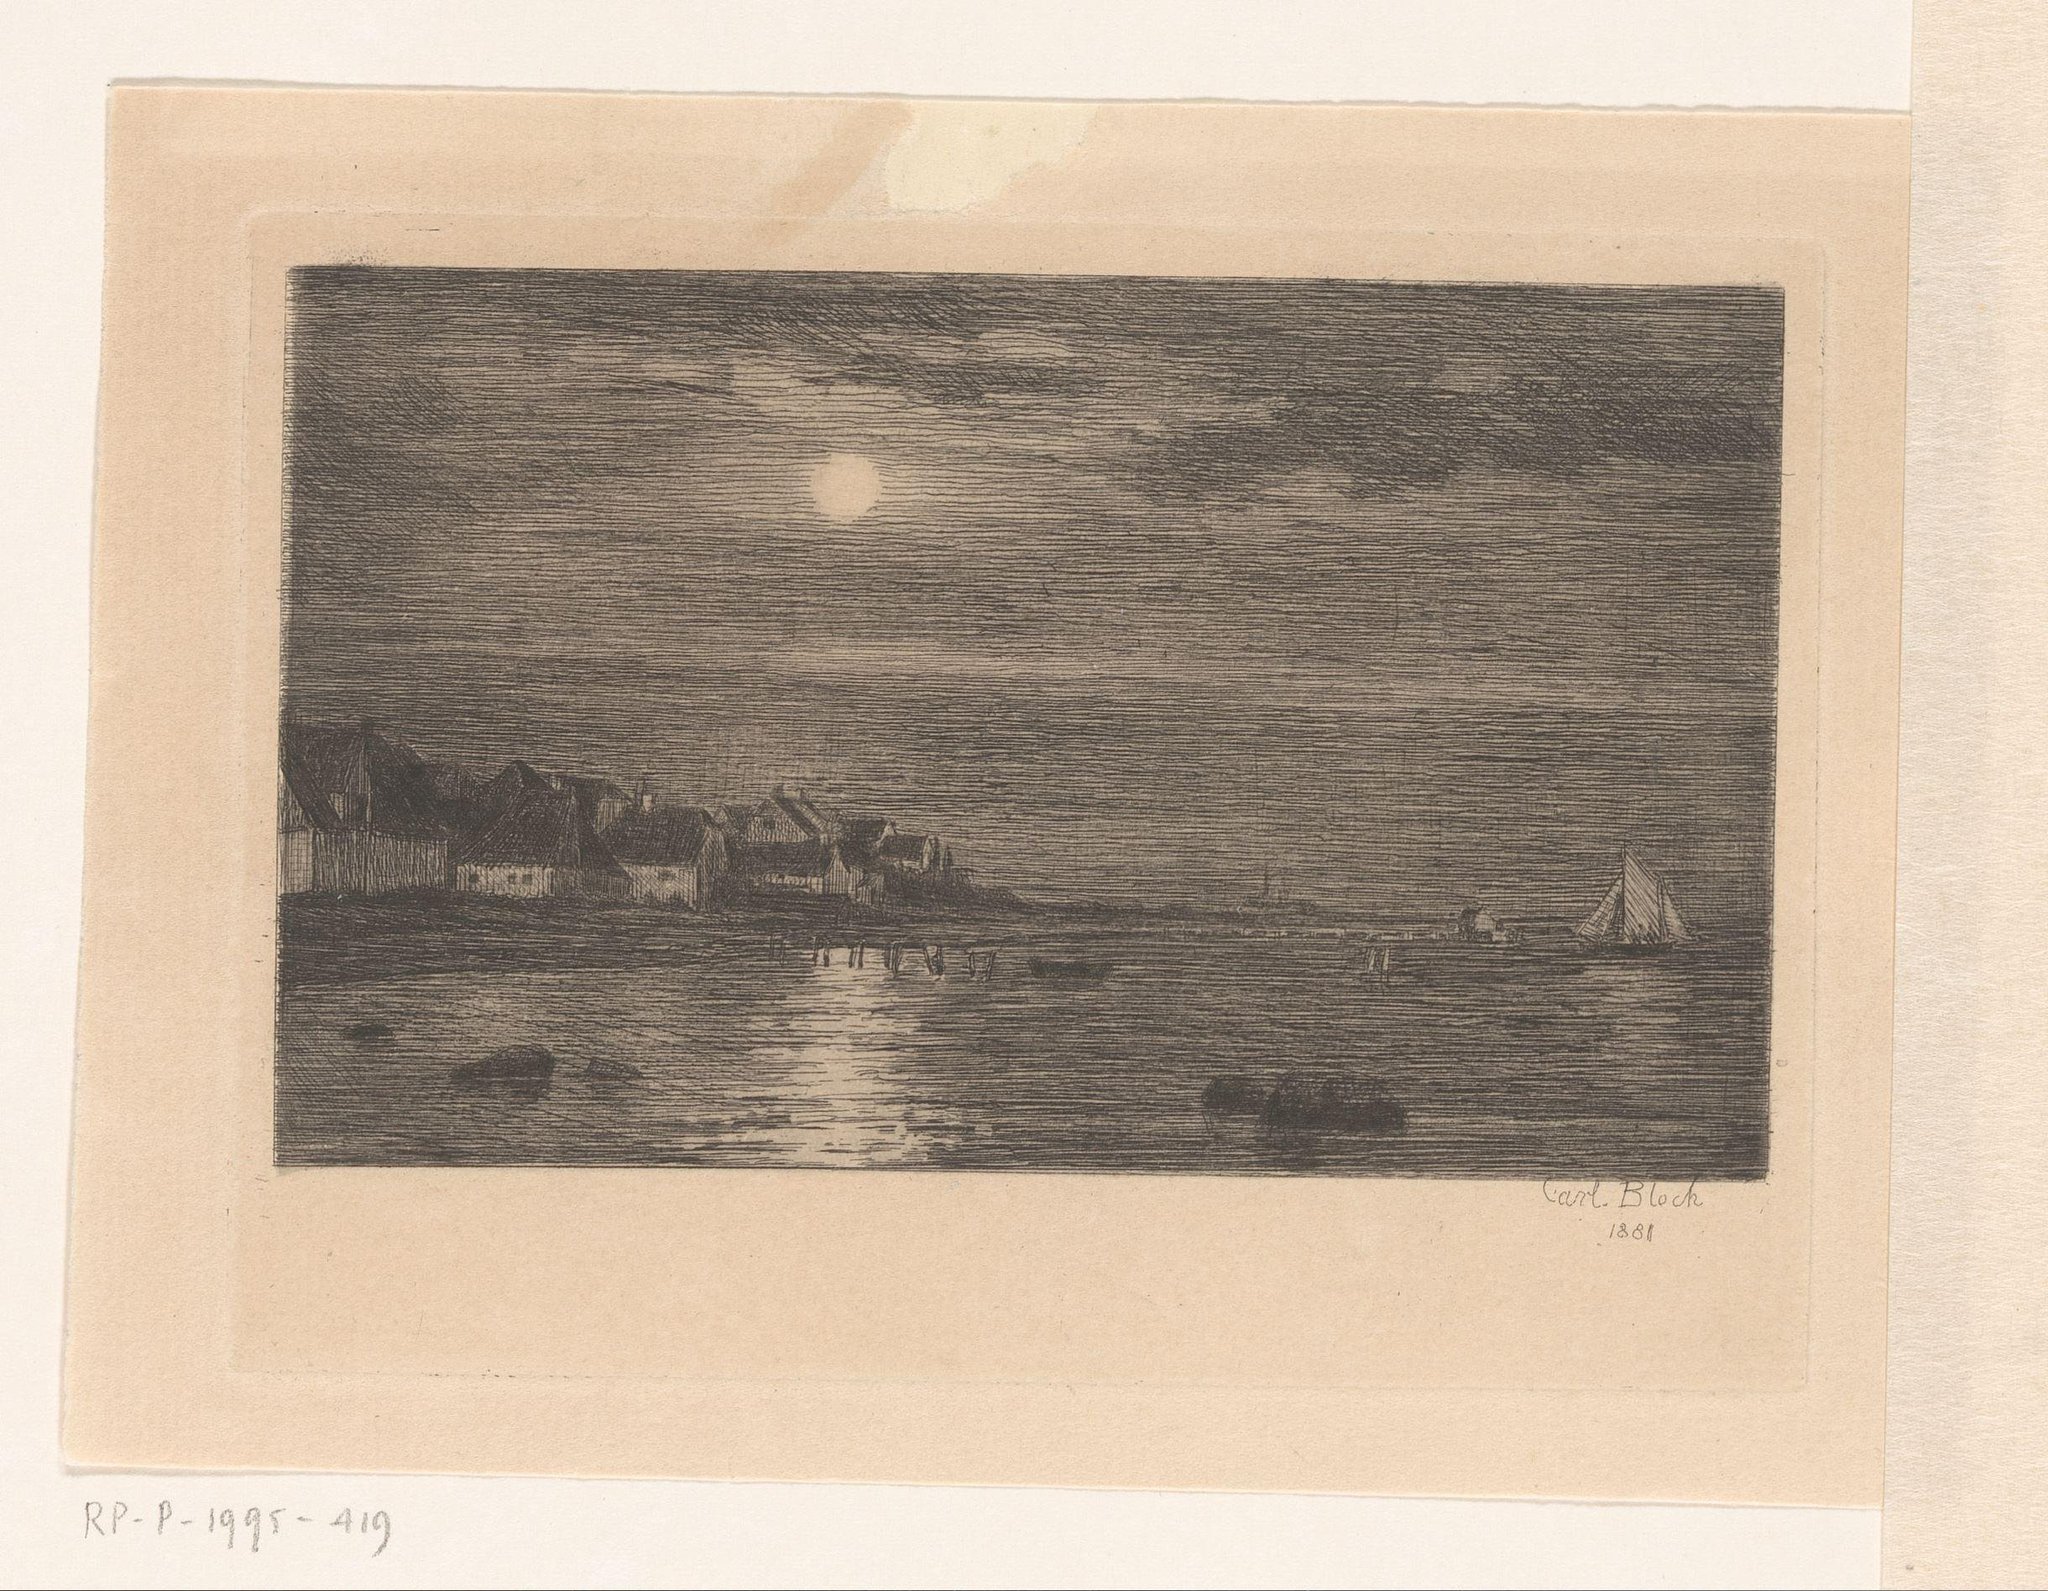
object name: print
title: Dorpje aan het water, bij maanlicht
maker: carl bloch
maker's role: print maker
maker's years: 1834-1890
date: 1881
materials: paper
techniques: drypoint, etching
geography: scandinavia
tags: moonlight, lake, night ~ landscape (sometimes titled 'nox')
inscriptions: signature and date: ‘r.o. in de marge gesigneerd en gedateerd Carl Bloch 1881’, collector's mark: Lugt 2228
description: Water met zeilbootjes op de achtergrond; links een dorpje van lage witte huisjes. Bij maanlicht.